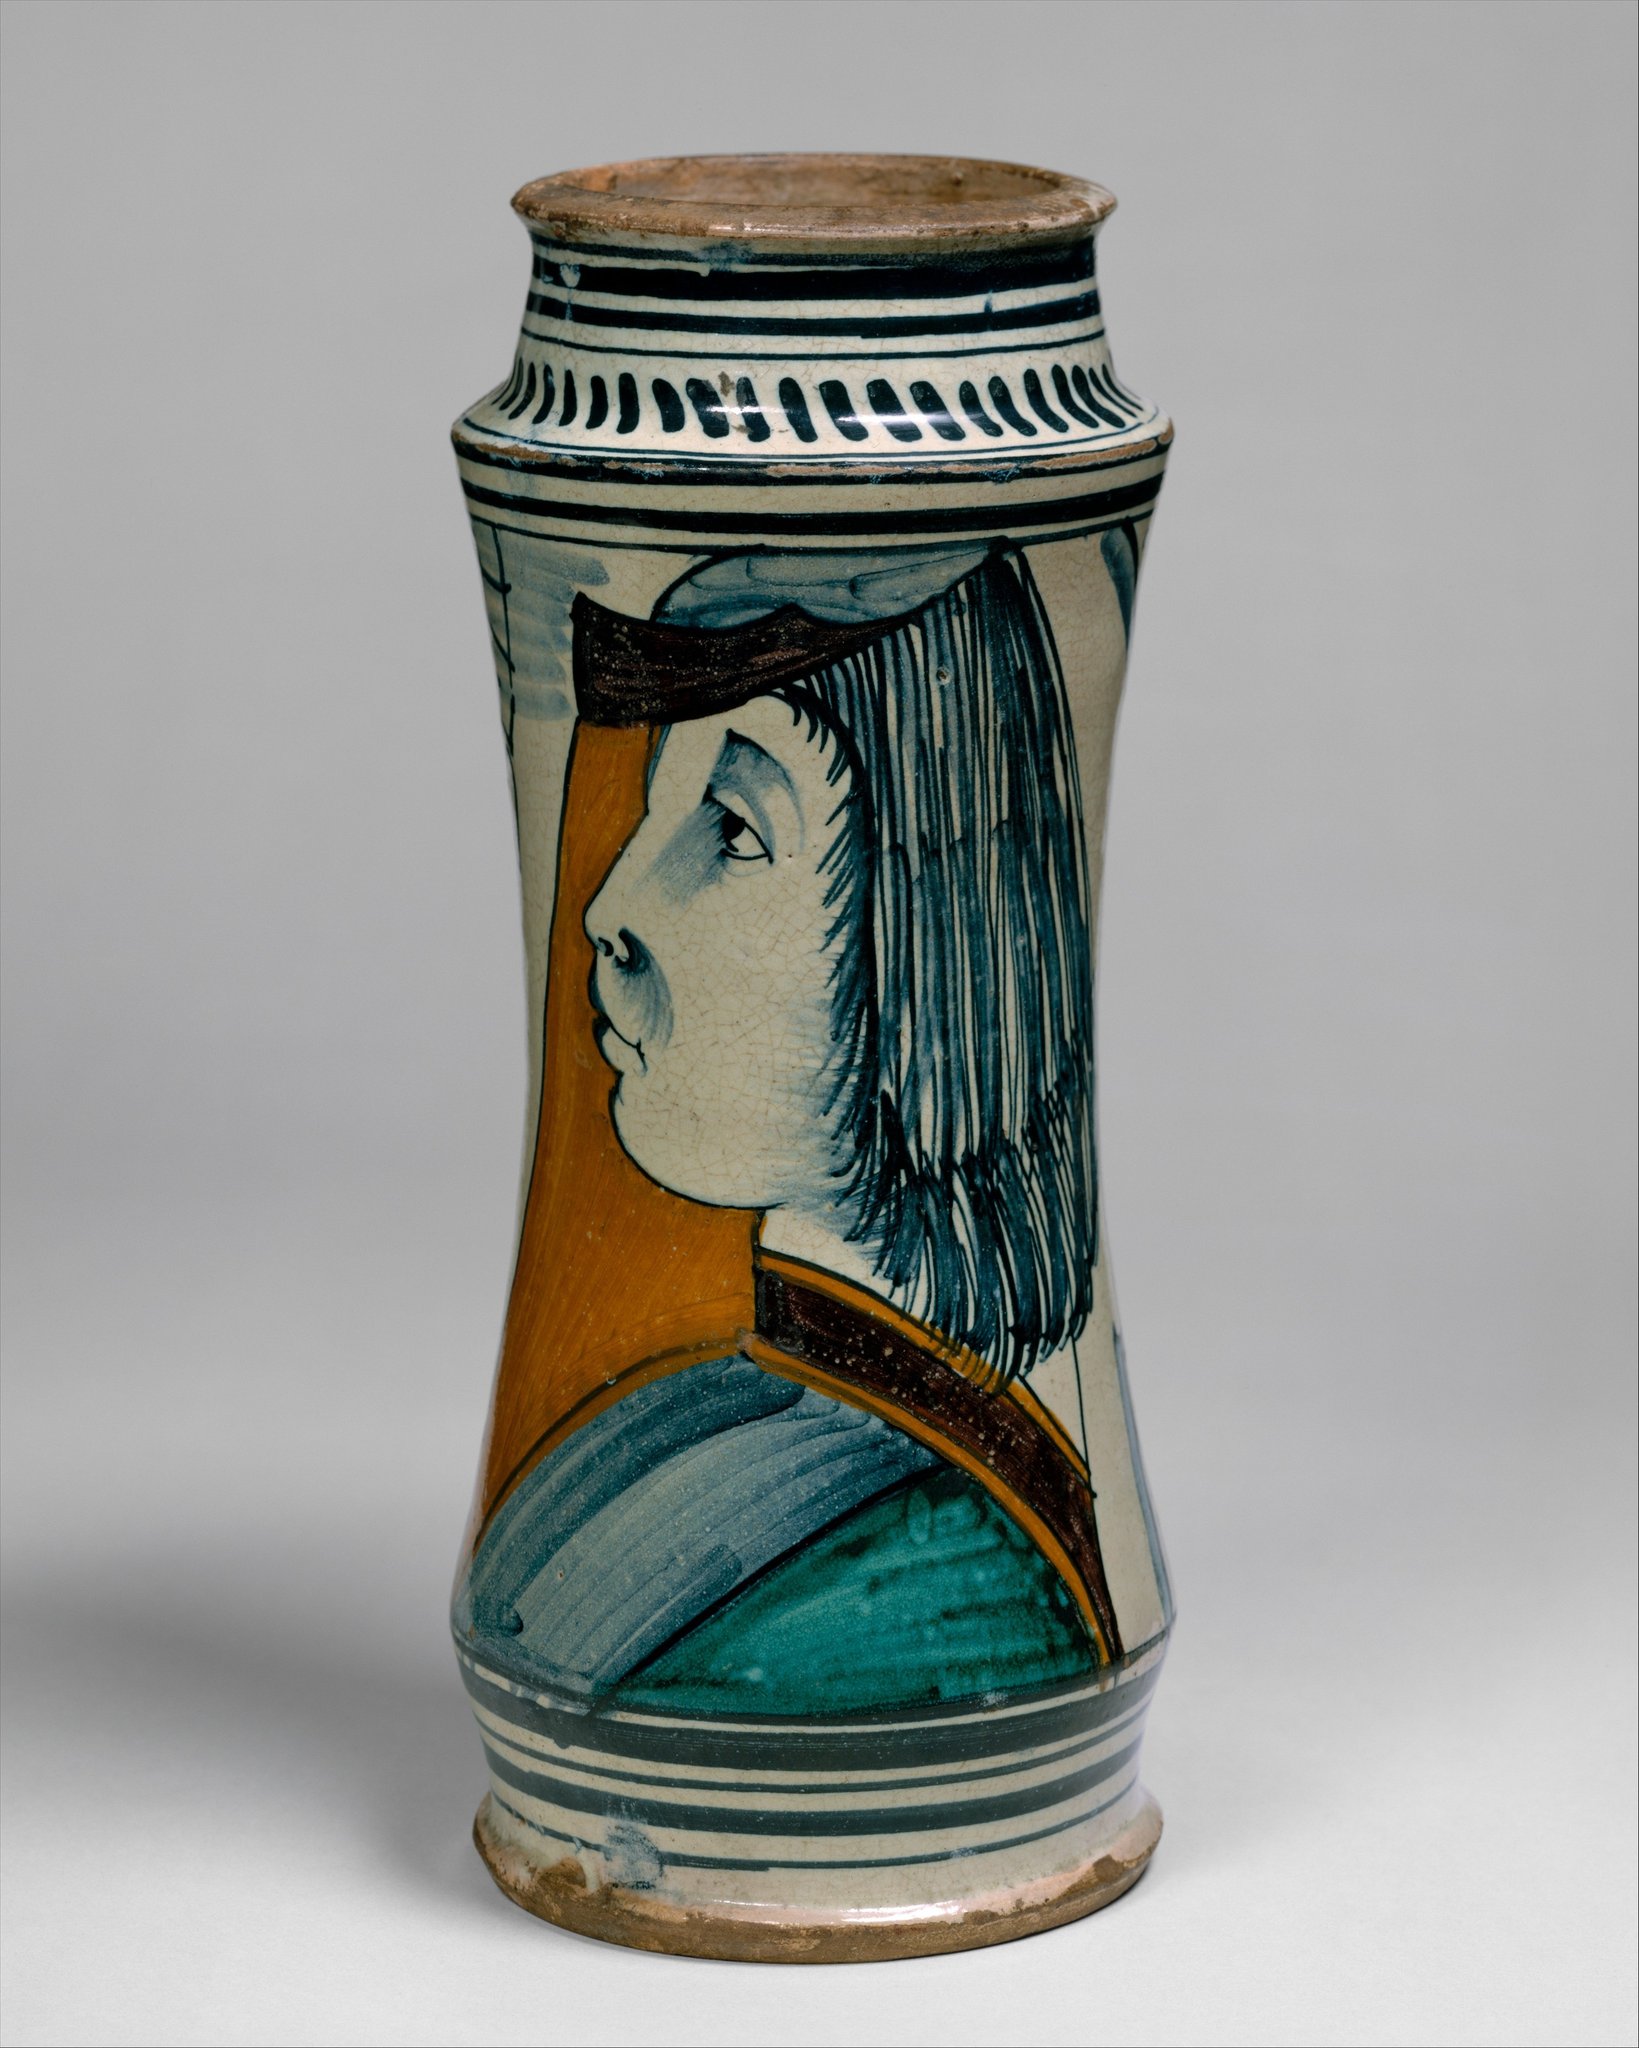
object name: albarello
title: Apothecary jar (albarello)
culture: italian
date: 1480-1500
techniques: maiolica, glazing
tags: men